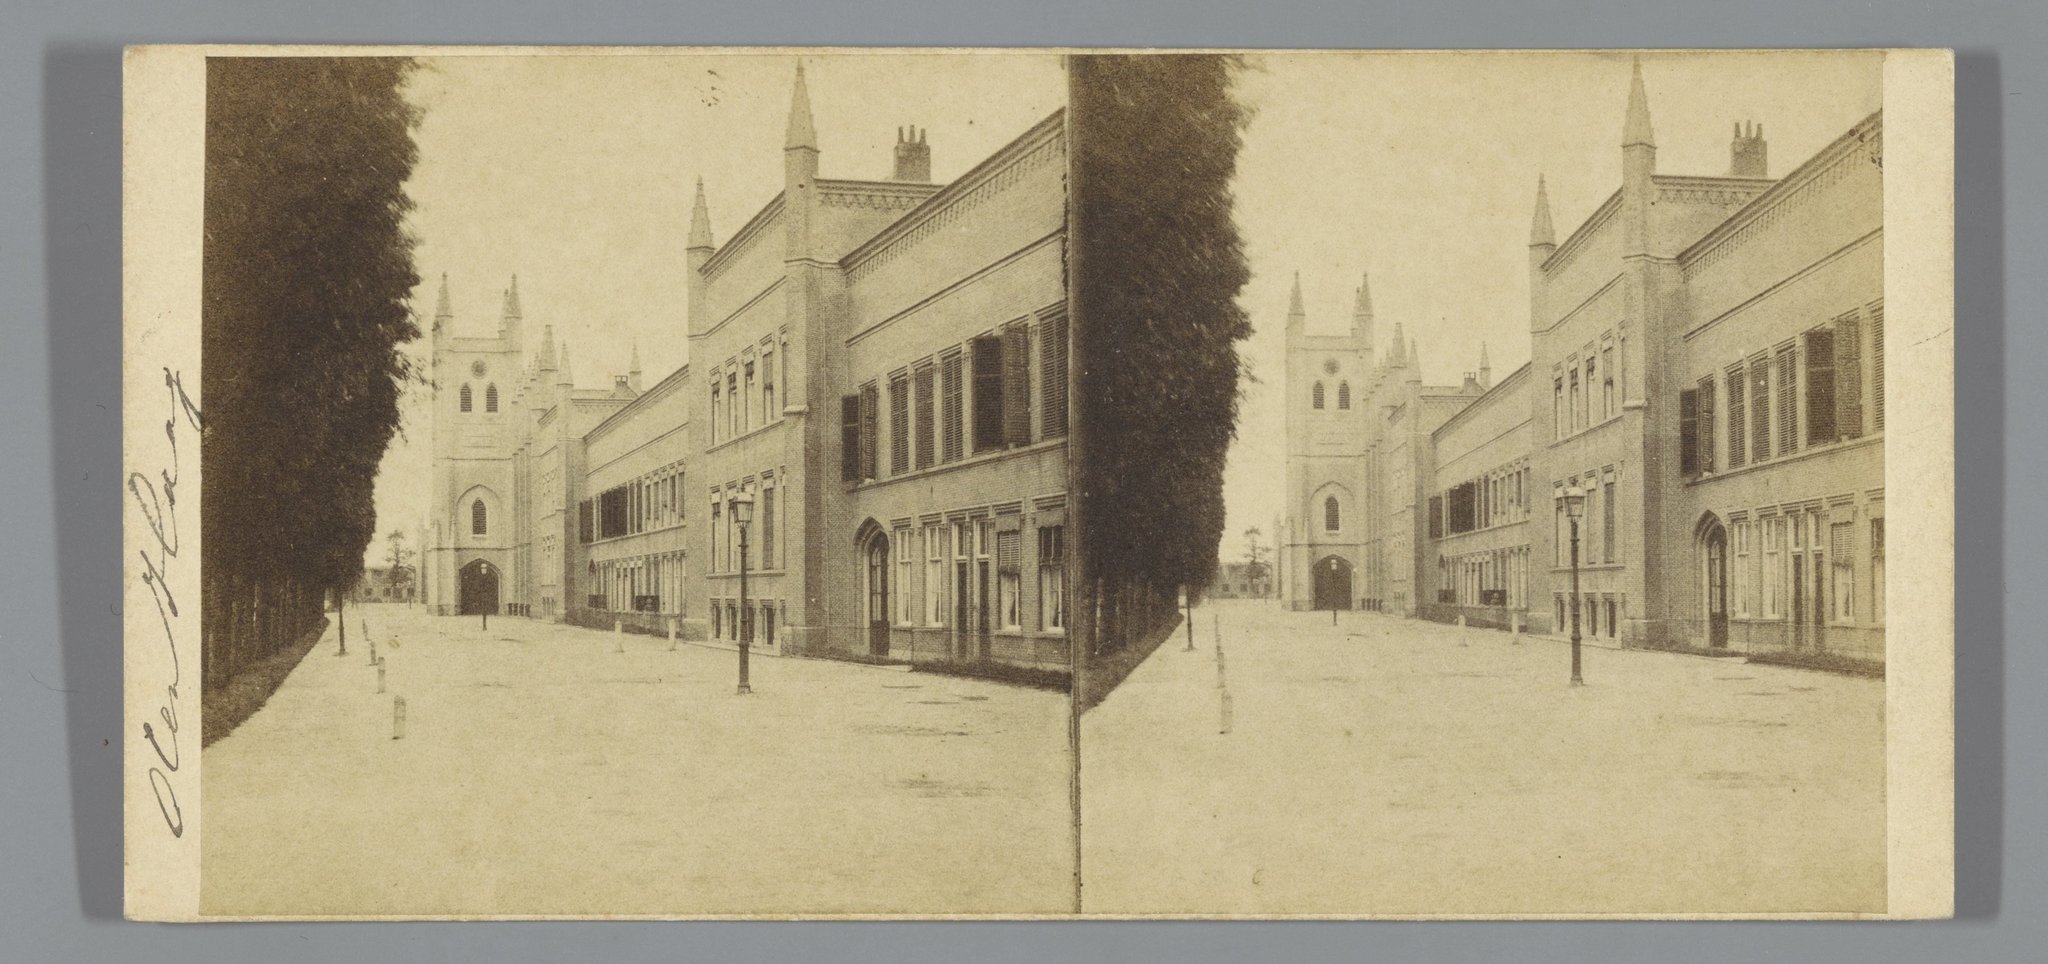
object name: stereograph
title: Willemskerk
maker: pieter oosterhuis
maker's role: draughtsman, print maker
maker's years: 1816-1885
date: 1859-1865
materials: cardboard, paper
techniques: albumen print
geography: the hague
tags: church (exterior)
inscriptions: inscription: ‘den Haag’, inscription: ‘P.’, number: ‘No. 242.’, number: ‘5’